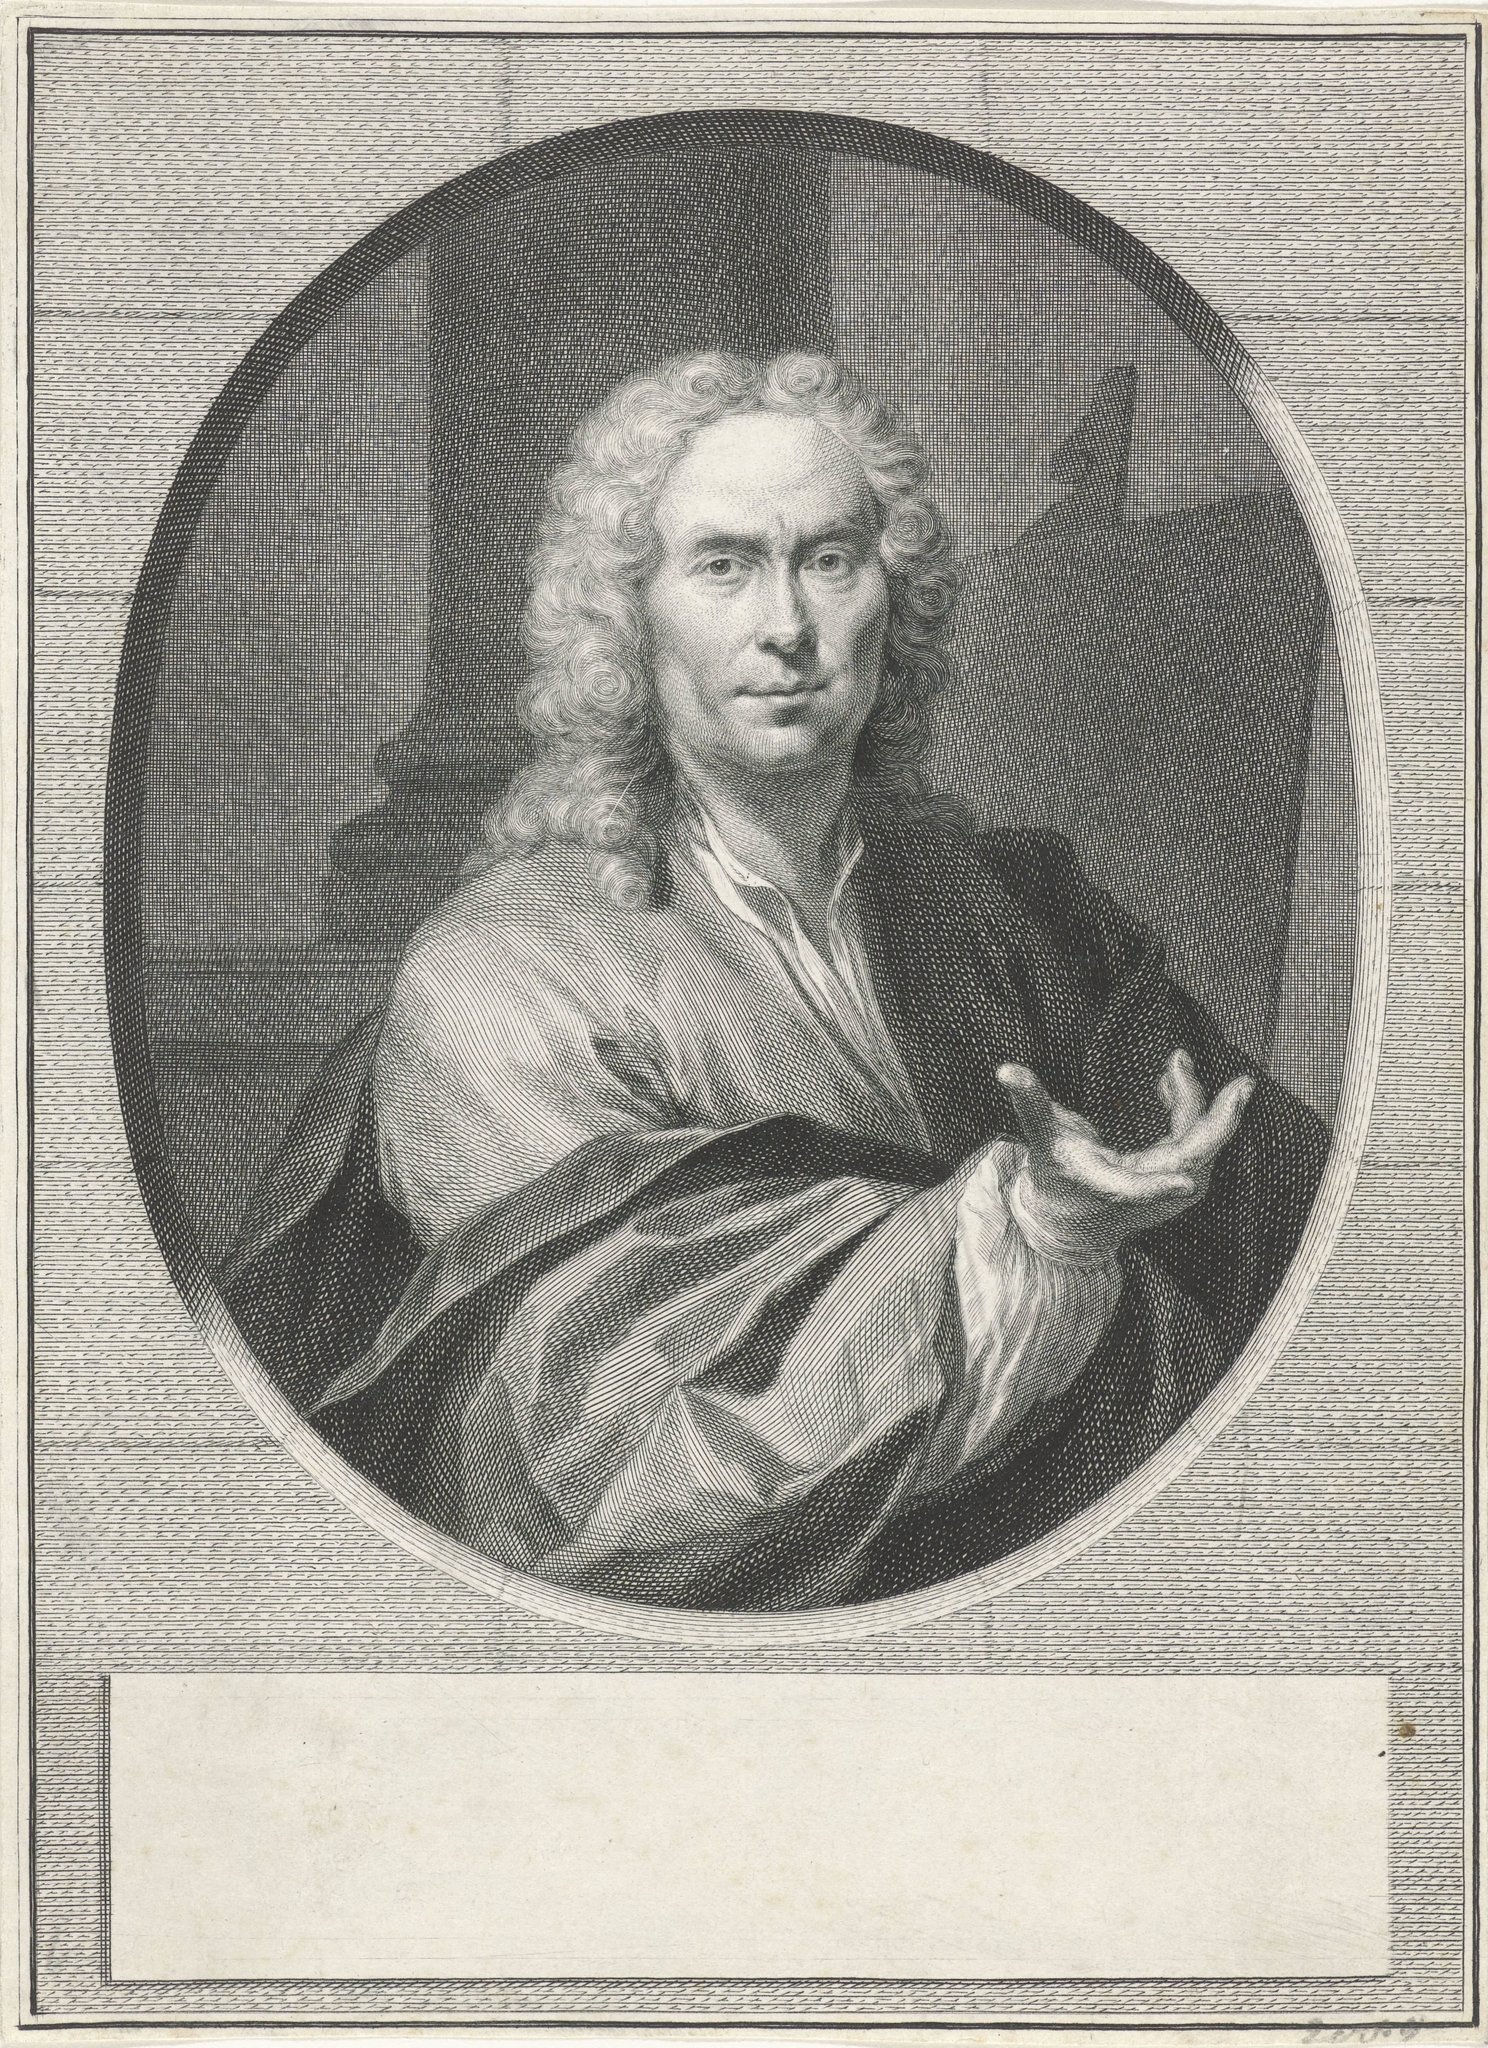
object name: print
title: Portret van Nicolaas Verkolje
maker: jacob houbraken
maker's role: draughtsman, print maker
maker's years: 1698-1780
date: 1751-1753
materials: paper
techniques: engraving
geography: amsterdam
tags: delft, amsterdam, print maker, draughtsman, nicolaas verkolje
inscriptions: collector's mark: Lugt 2228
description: Portret ten hlaven lijve naar rechts van Nicolaas Verkolje in een architectonisch ovaal, met achter hem een zuil en een schildersezel. Onder het portret een leeg veld.